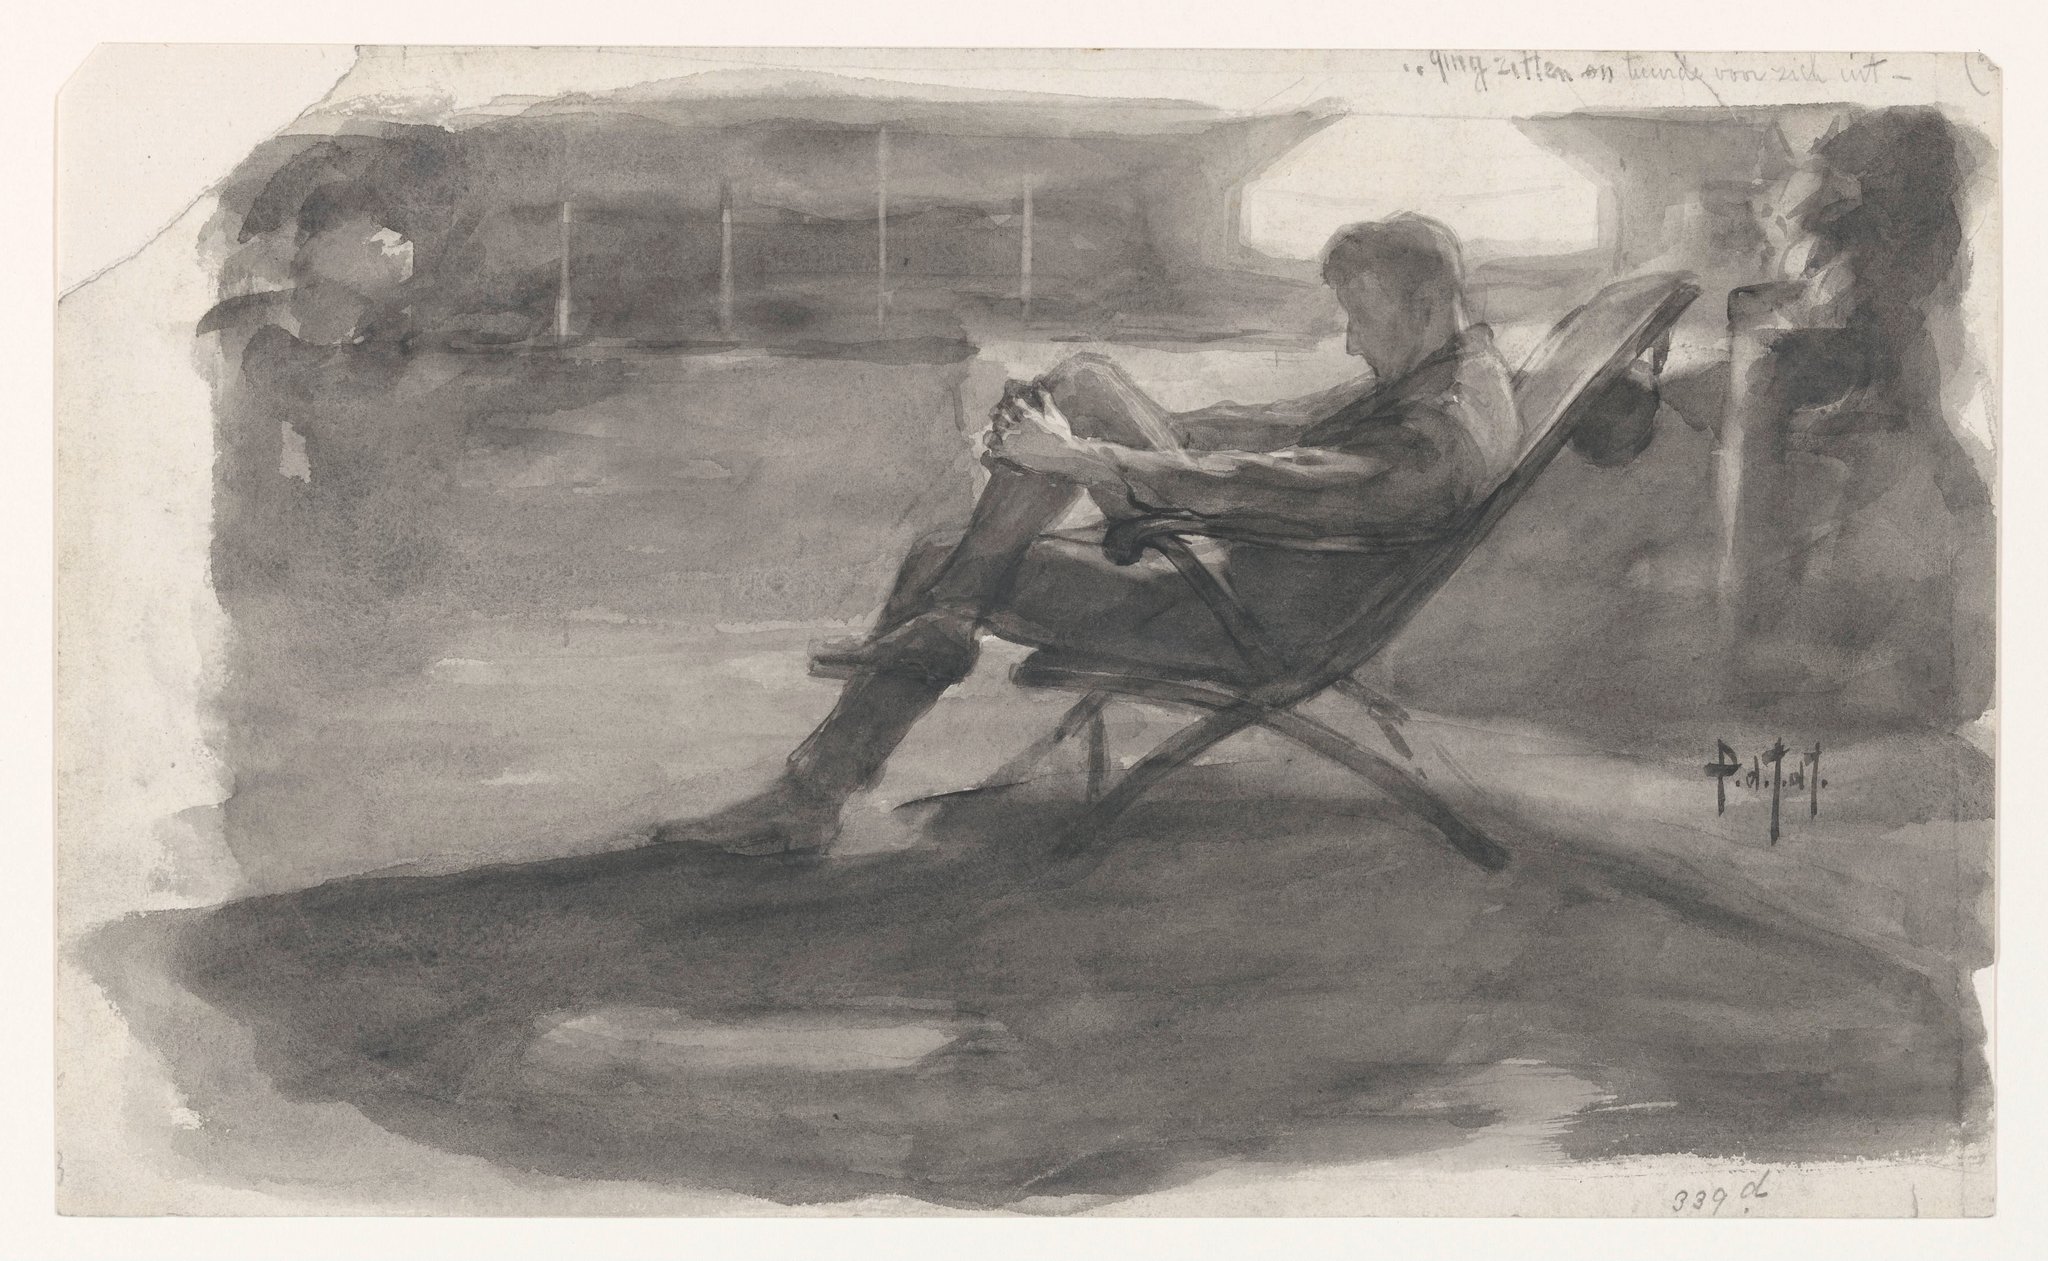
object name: design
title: Zittende man in tuinstoel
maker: pieter de josselin de jong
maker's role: draughtsman, painter, print maker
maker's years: 1861-1906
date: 1871-1906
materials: paper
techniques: brush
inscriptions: inscription: ‘ging zitten en tuurde voor zich uit’